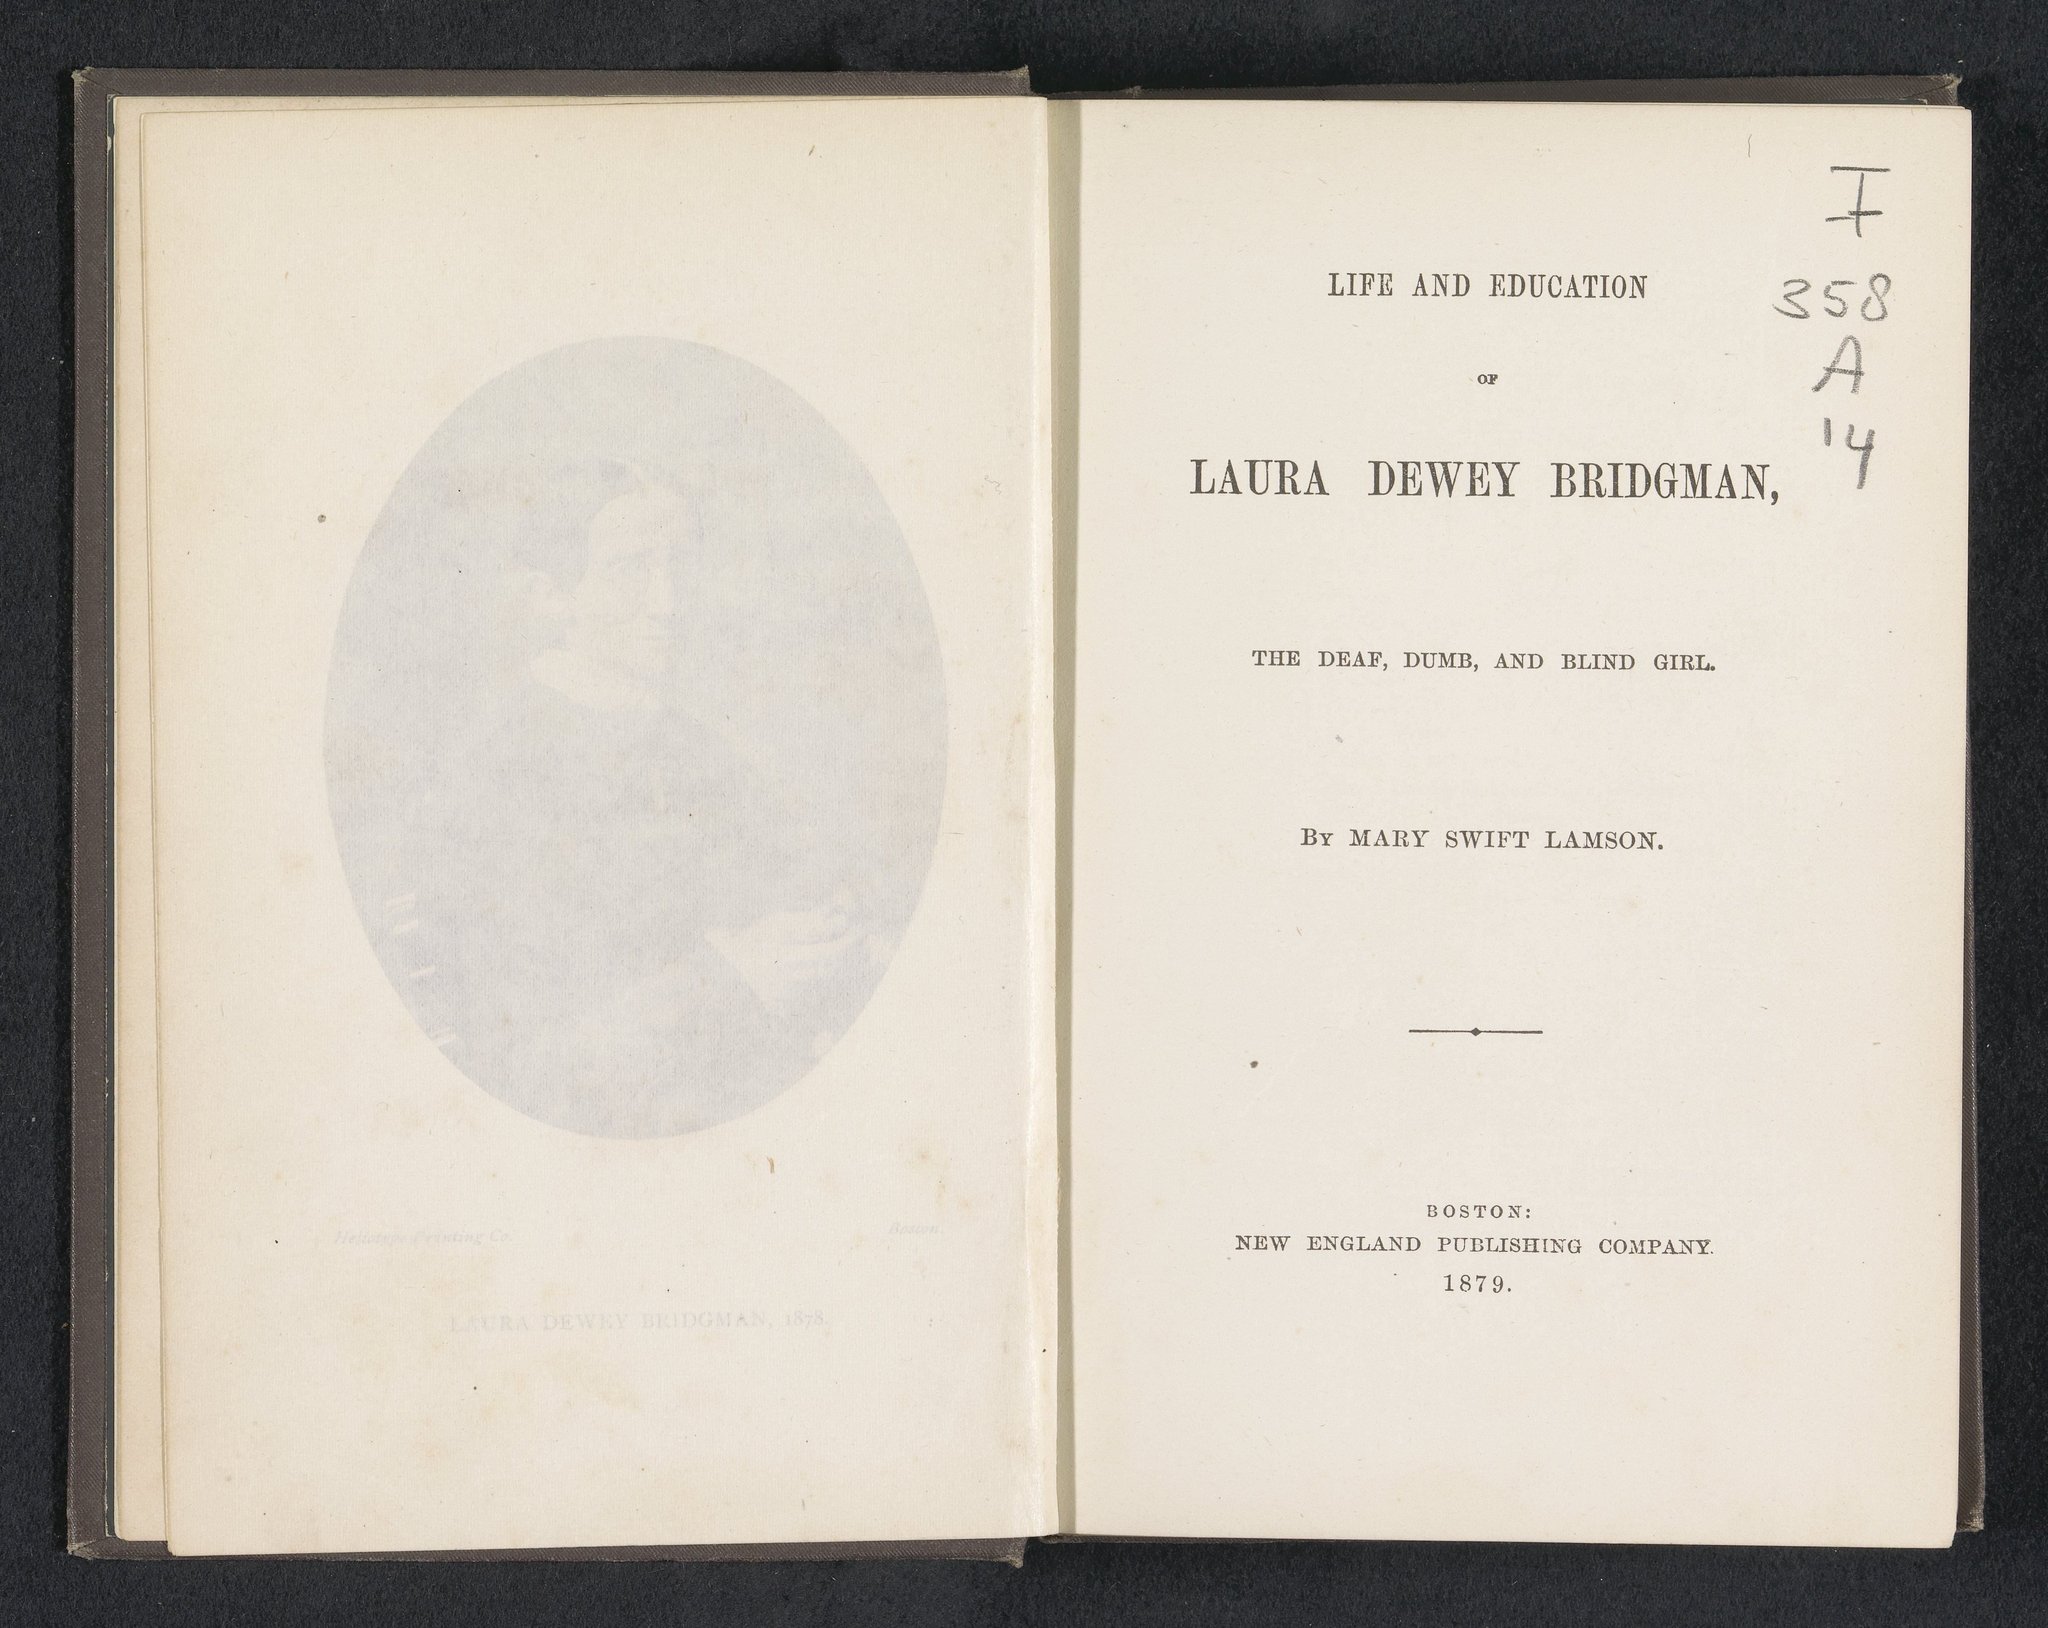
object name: book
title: Life and education of Laura Dewey Bridgman, the deaf, dumb, and blind girl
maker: mary swift lamson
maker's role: schrijver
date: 1879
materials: cardboard, linen, paper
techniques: photograph, lithograph, printing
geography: boston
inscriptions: number: ‘24’